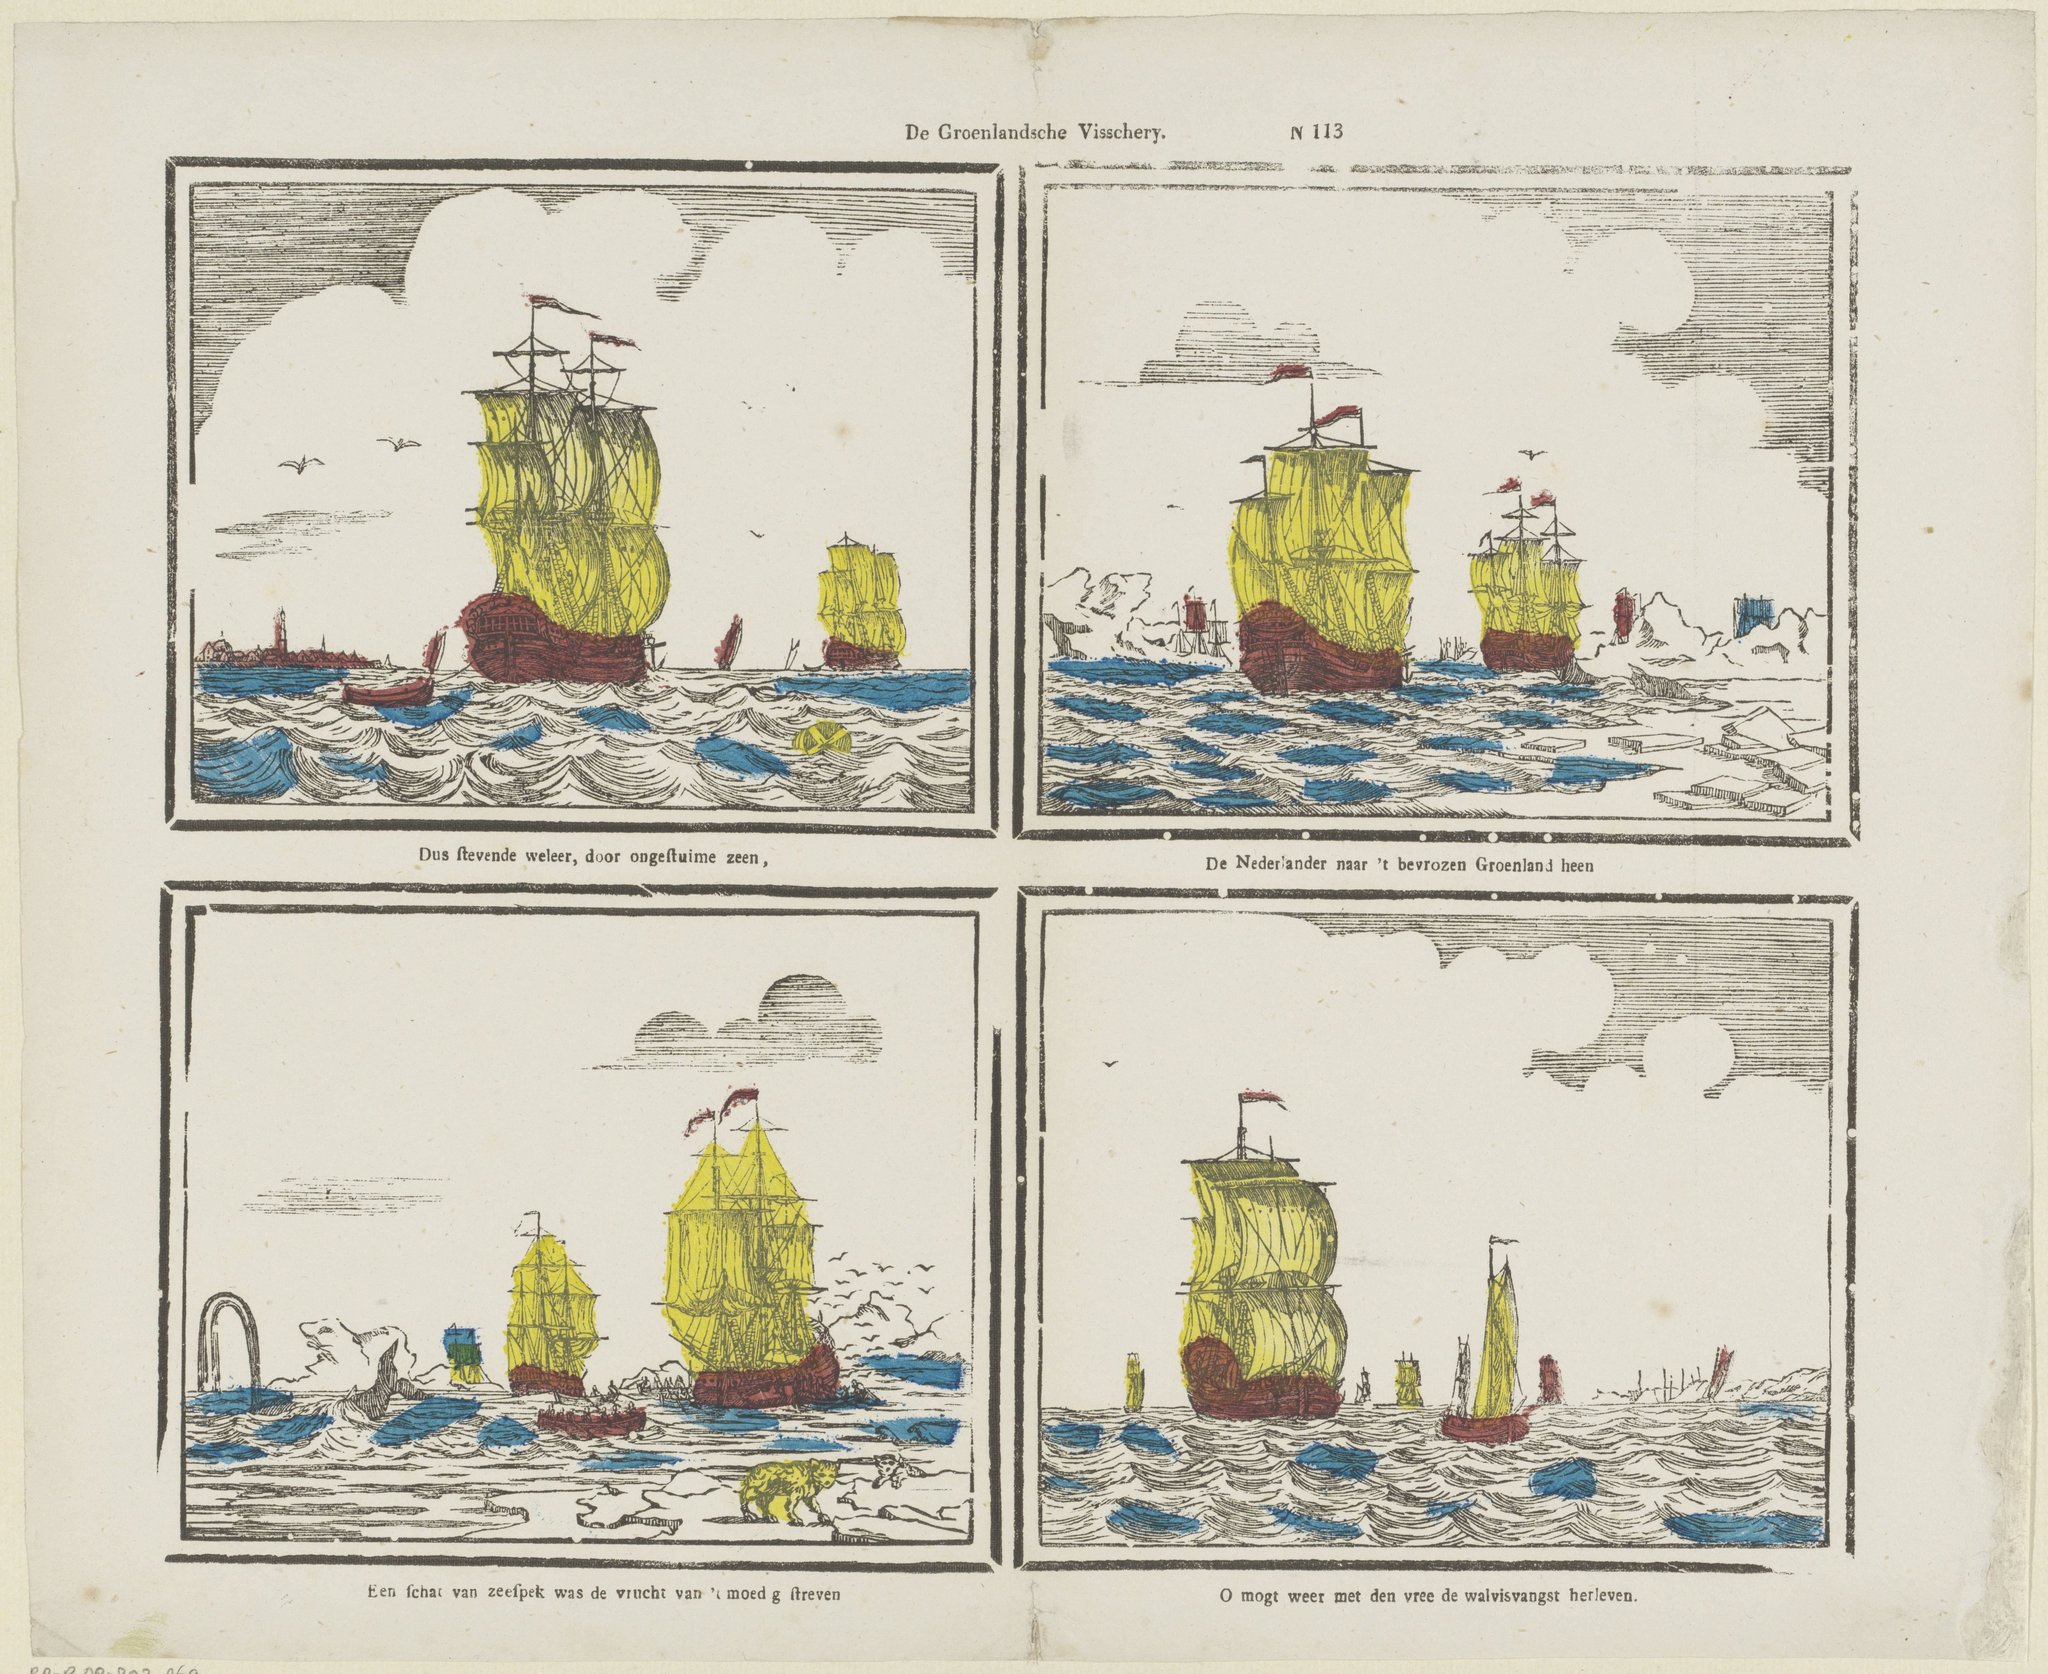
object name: print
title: De Groenlandsche Visschery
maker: Anonymous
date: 1856-1900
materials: paper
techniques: colour, letterpress printing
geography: turnhout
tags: ships (in general), greenland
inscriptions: collector's mark: Lugt 2760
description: Blad met 4 voorstellingen van schepen op zee. Onder elke afbeelding een onderschrift. Genummerd midden boven: N 113.